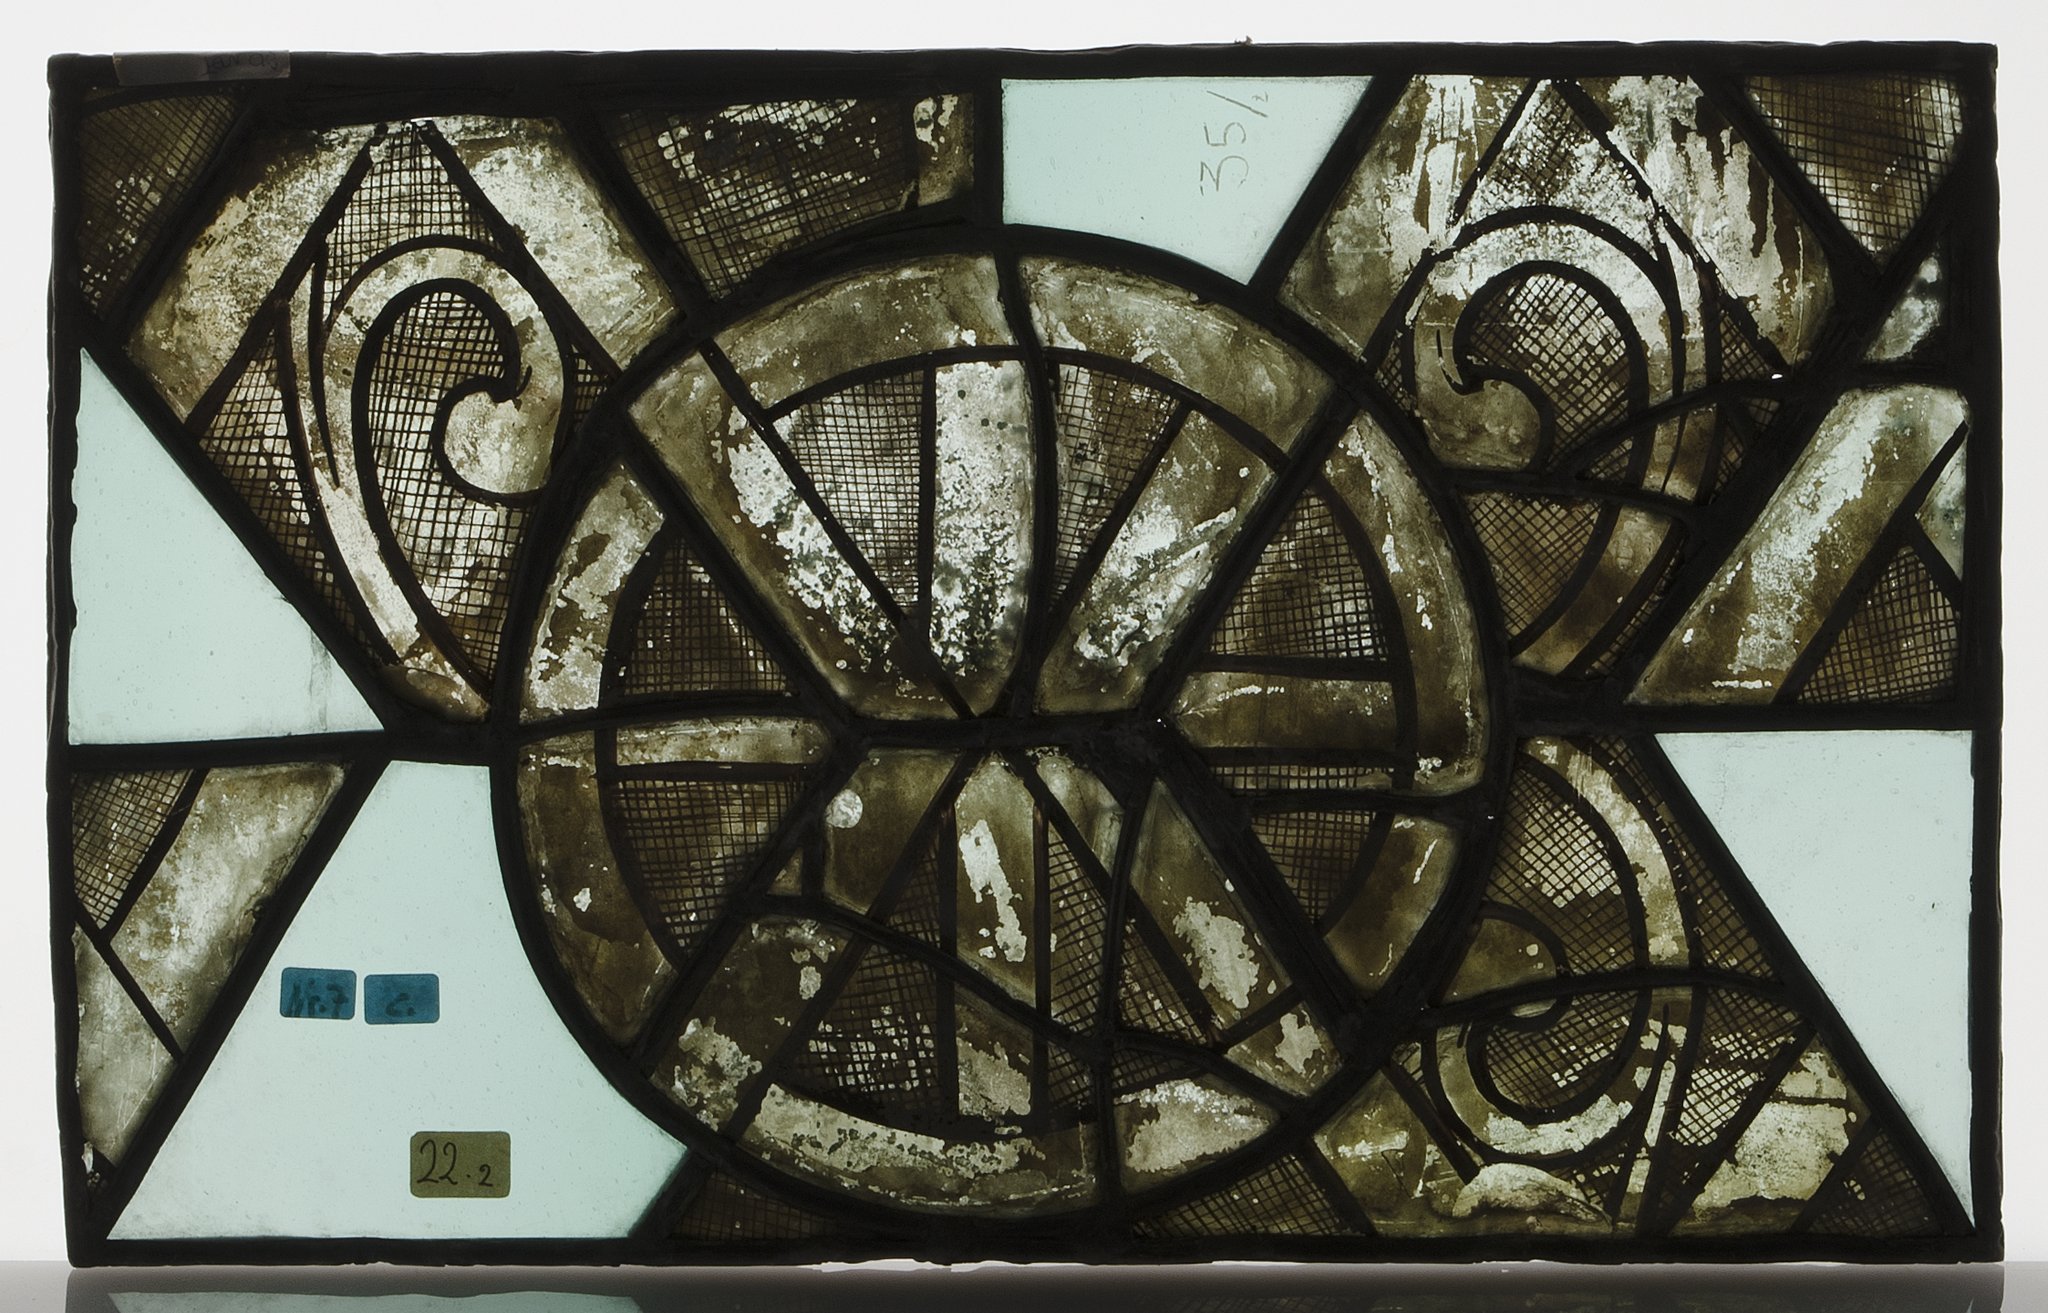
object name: panel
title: Grisalle Glass Panel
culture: french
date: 1260-1270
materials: glass, paint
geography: france